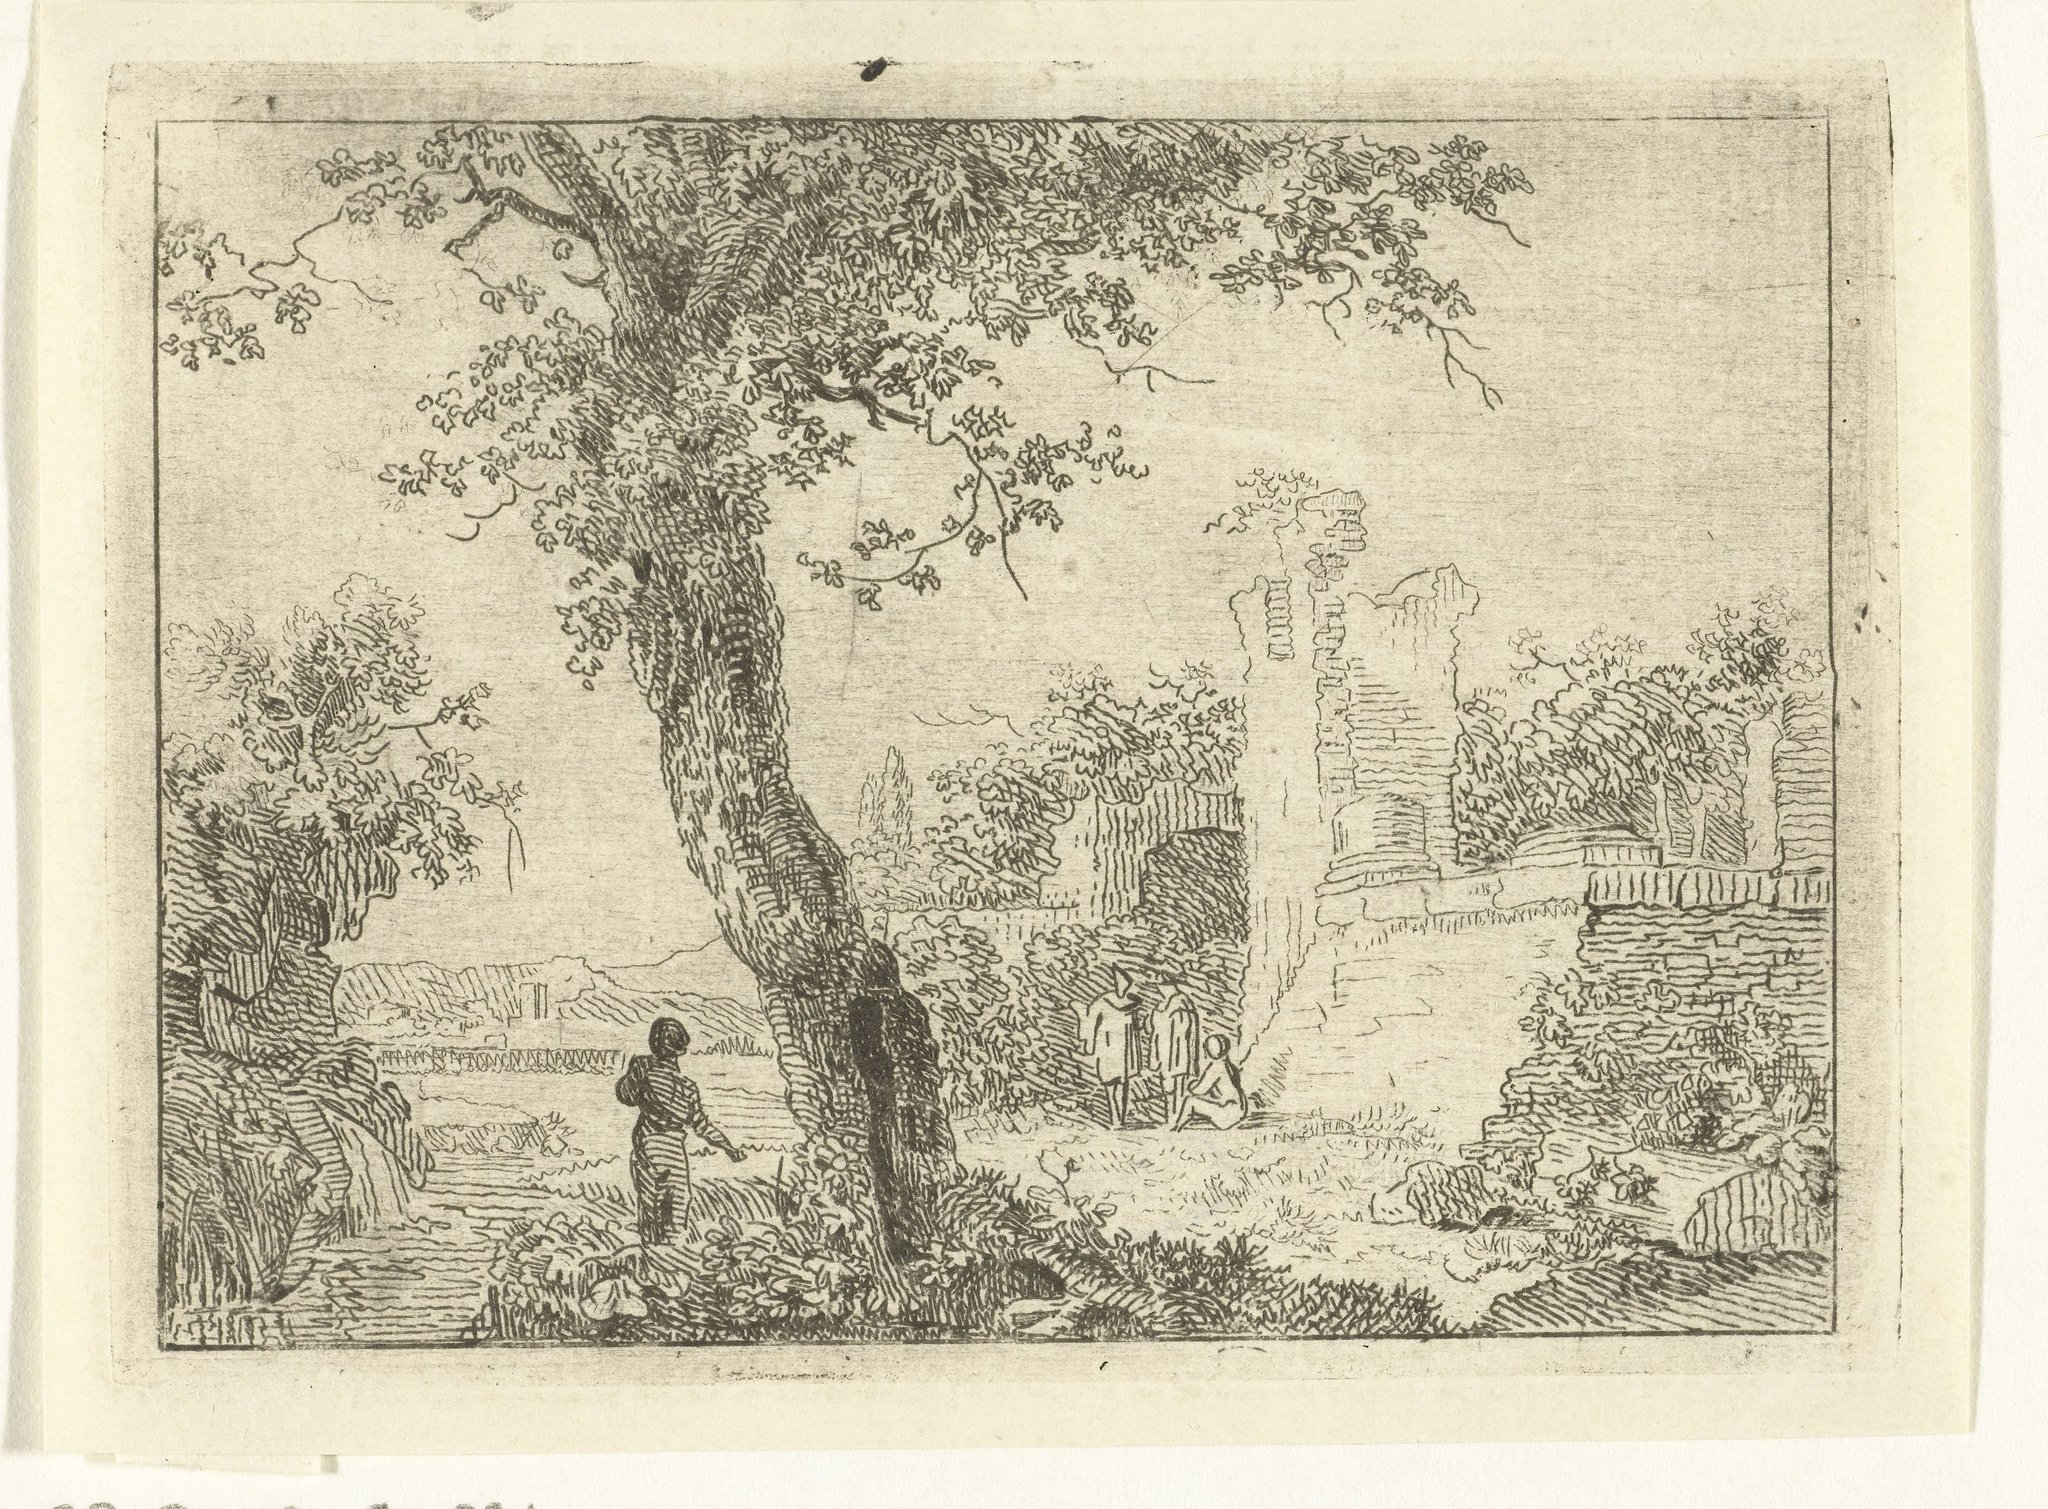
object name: print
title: Landschap met een ruïne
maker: gerardus emaus de micault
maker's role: draughtsman, print maker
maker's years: 1798-1863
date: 1813-1863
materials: paper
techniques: etching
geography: netherlands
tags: landscape with ruins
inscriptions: collector's mark: Lugt 2228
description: Landschap met drie personen bij een ruïne. Op de voorgrond een vierde persoon naast een boom.